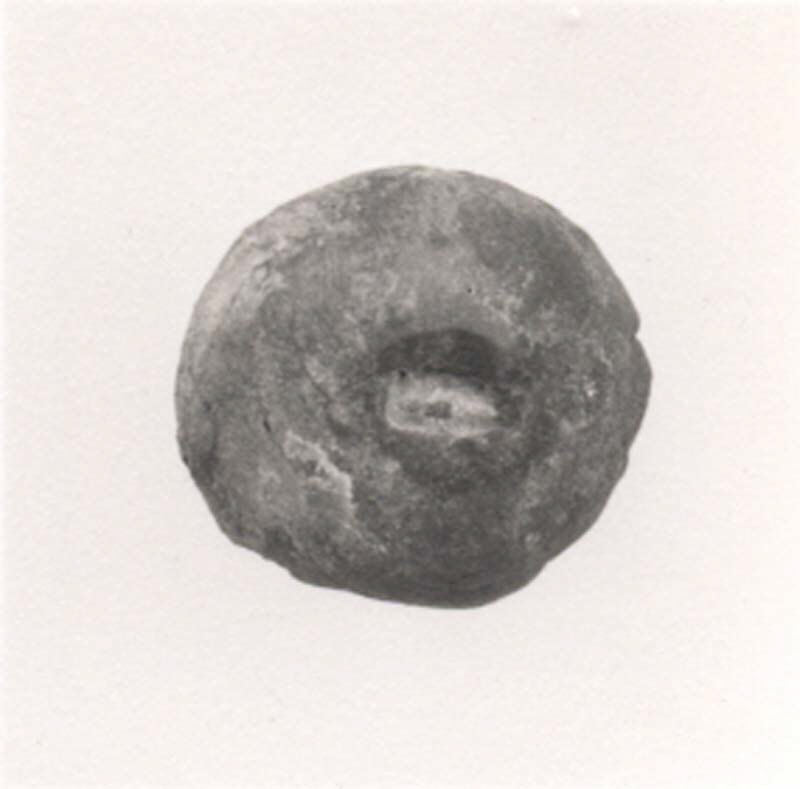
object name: sealing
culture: sasanian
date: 601-700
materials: clay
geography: iran